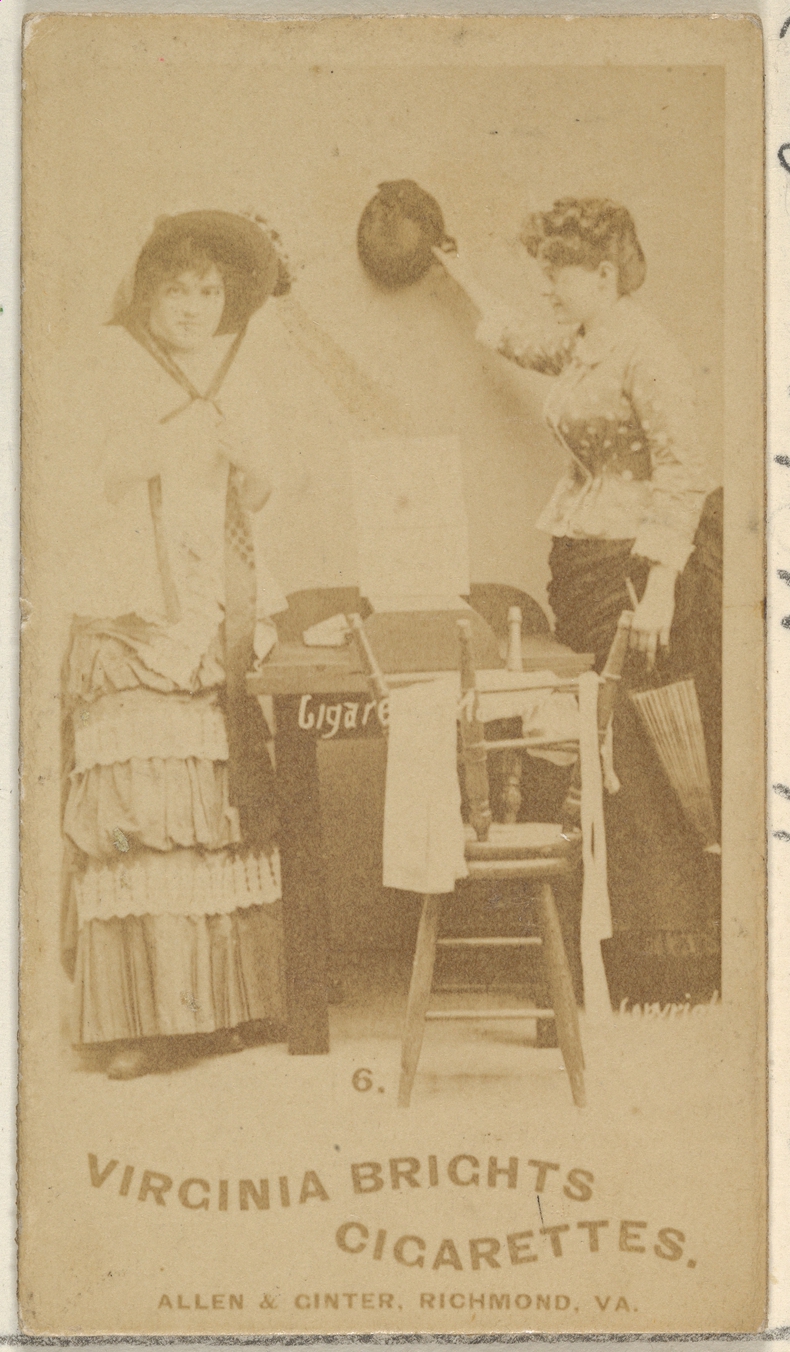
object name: photograph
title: Card 6, from the series, Cigarette Making Girls (N46) for Virginia Brights Cigarettes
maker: allen & ginter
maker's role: publisher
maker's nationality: american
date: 1888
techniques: albumen silver print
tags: women